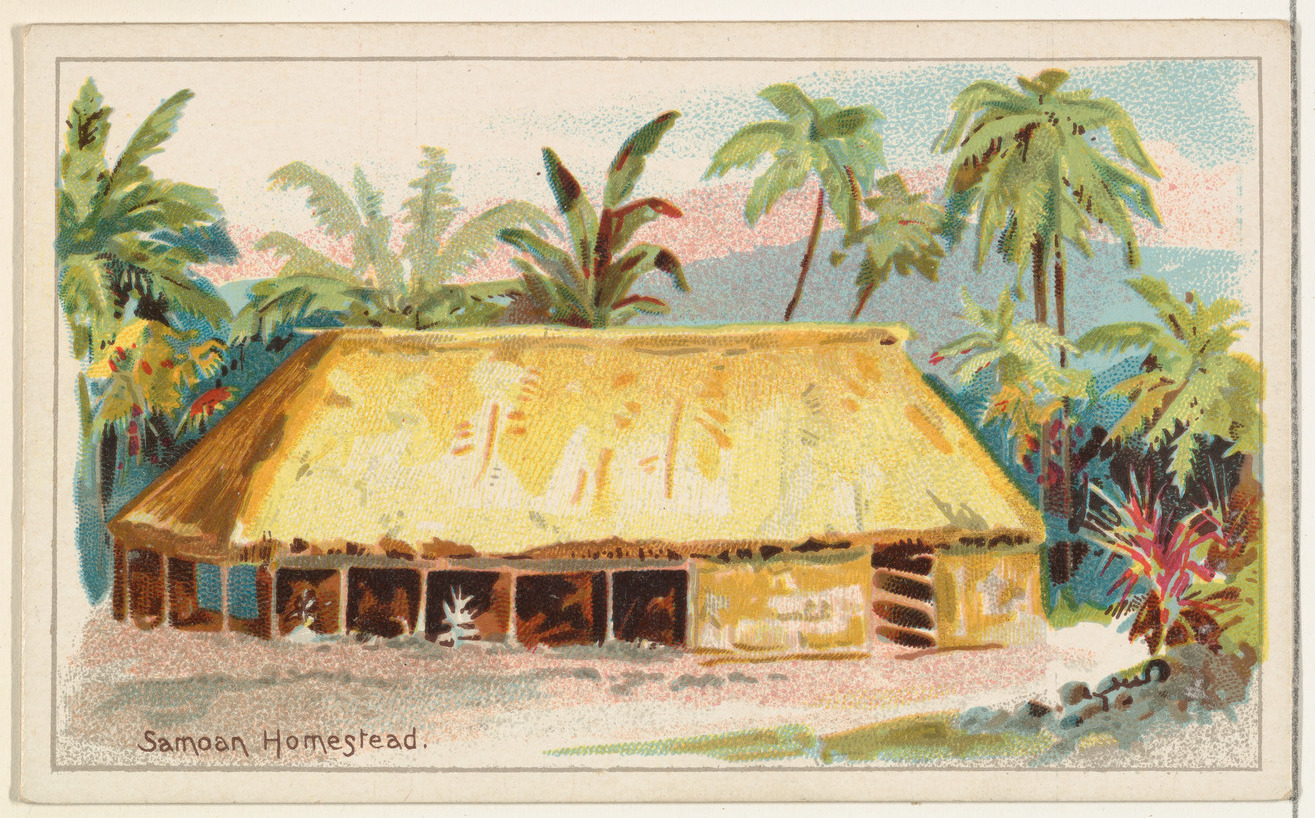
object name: print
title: Samoan Homestead, from the Habitations of Man series (N113) issued by W. Duke, Sons & Co. to promote Honest Long Cut Smoking and Chewing Tobacco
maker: the giles company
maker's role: artist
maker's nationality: american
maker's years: 1800-1900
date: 1890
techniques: color lithograph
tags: houses,trees